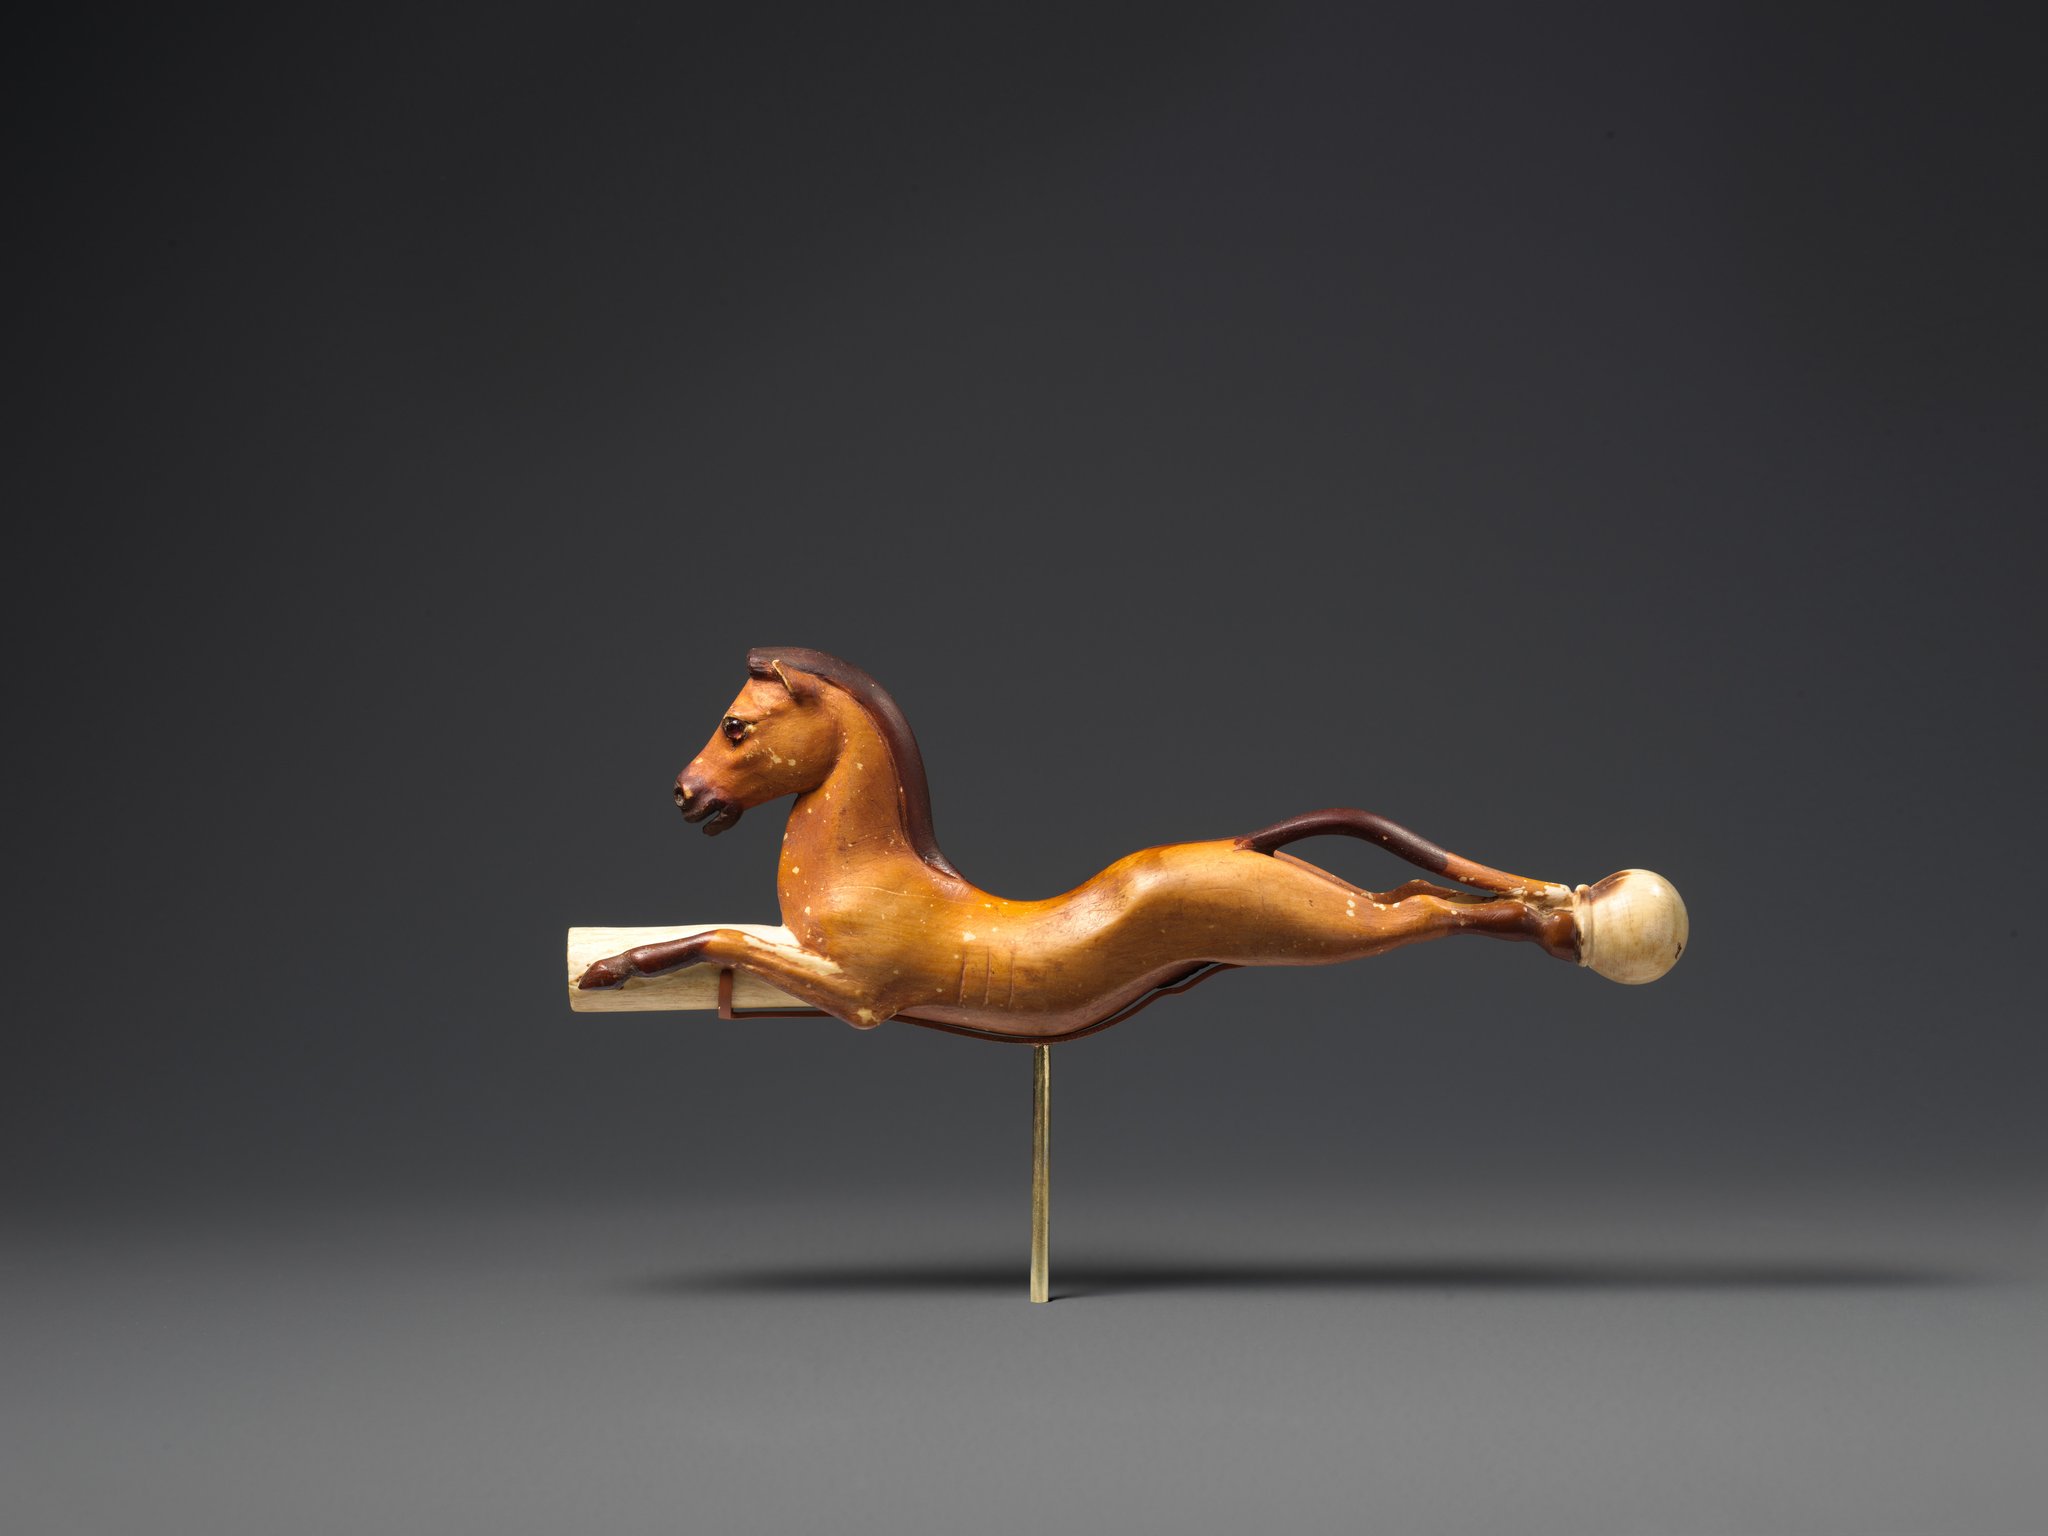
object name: whip handle, horse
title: Whip Handle in the Shape of a Horse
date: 1390-1352 BCE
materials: gemstone, ivory, paint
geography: egypt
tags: horses